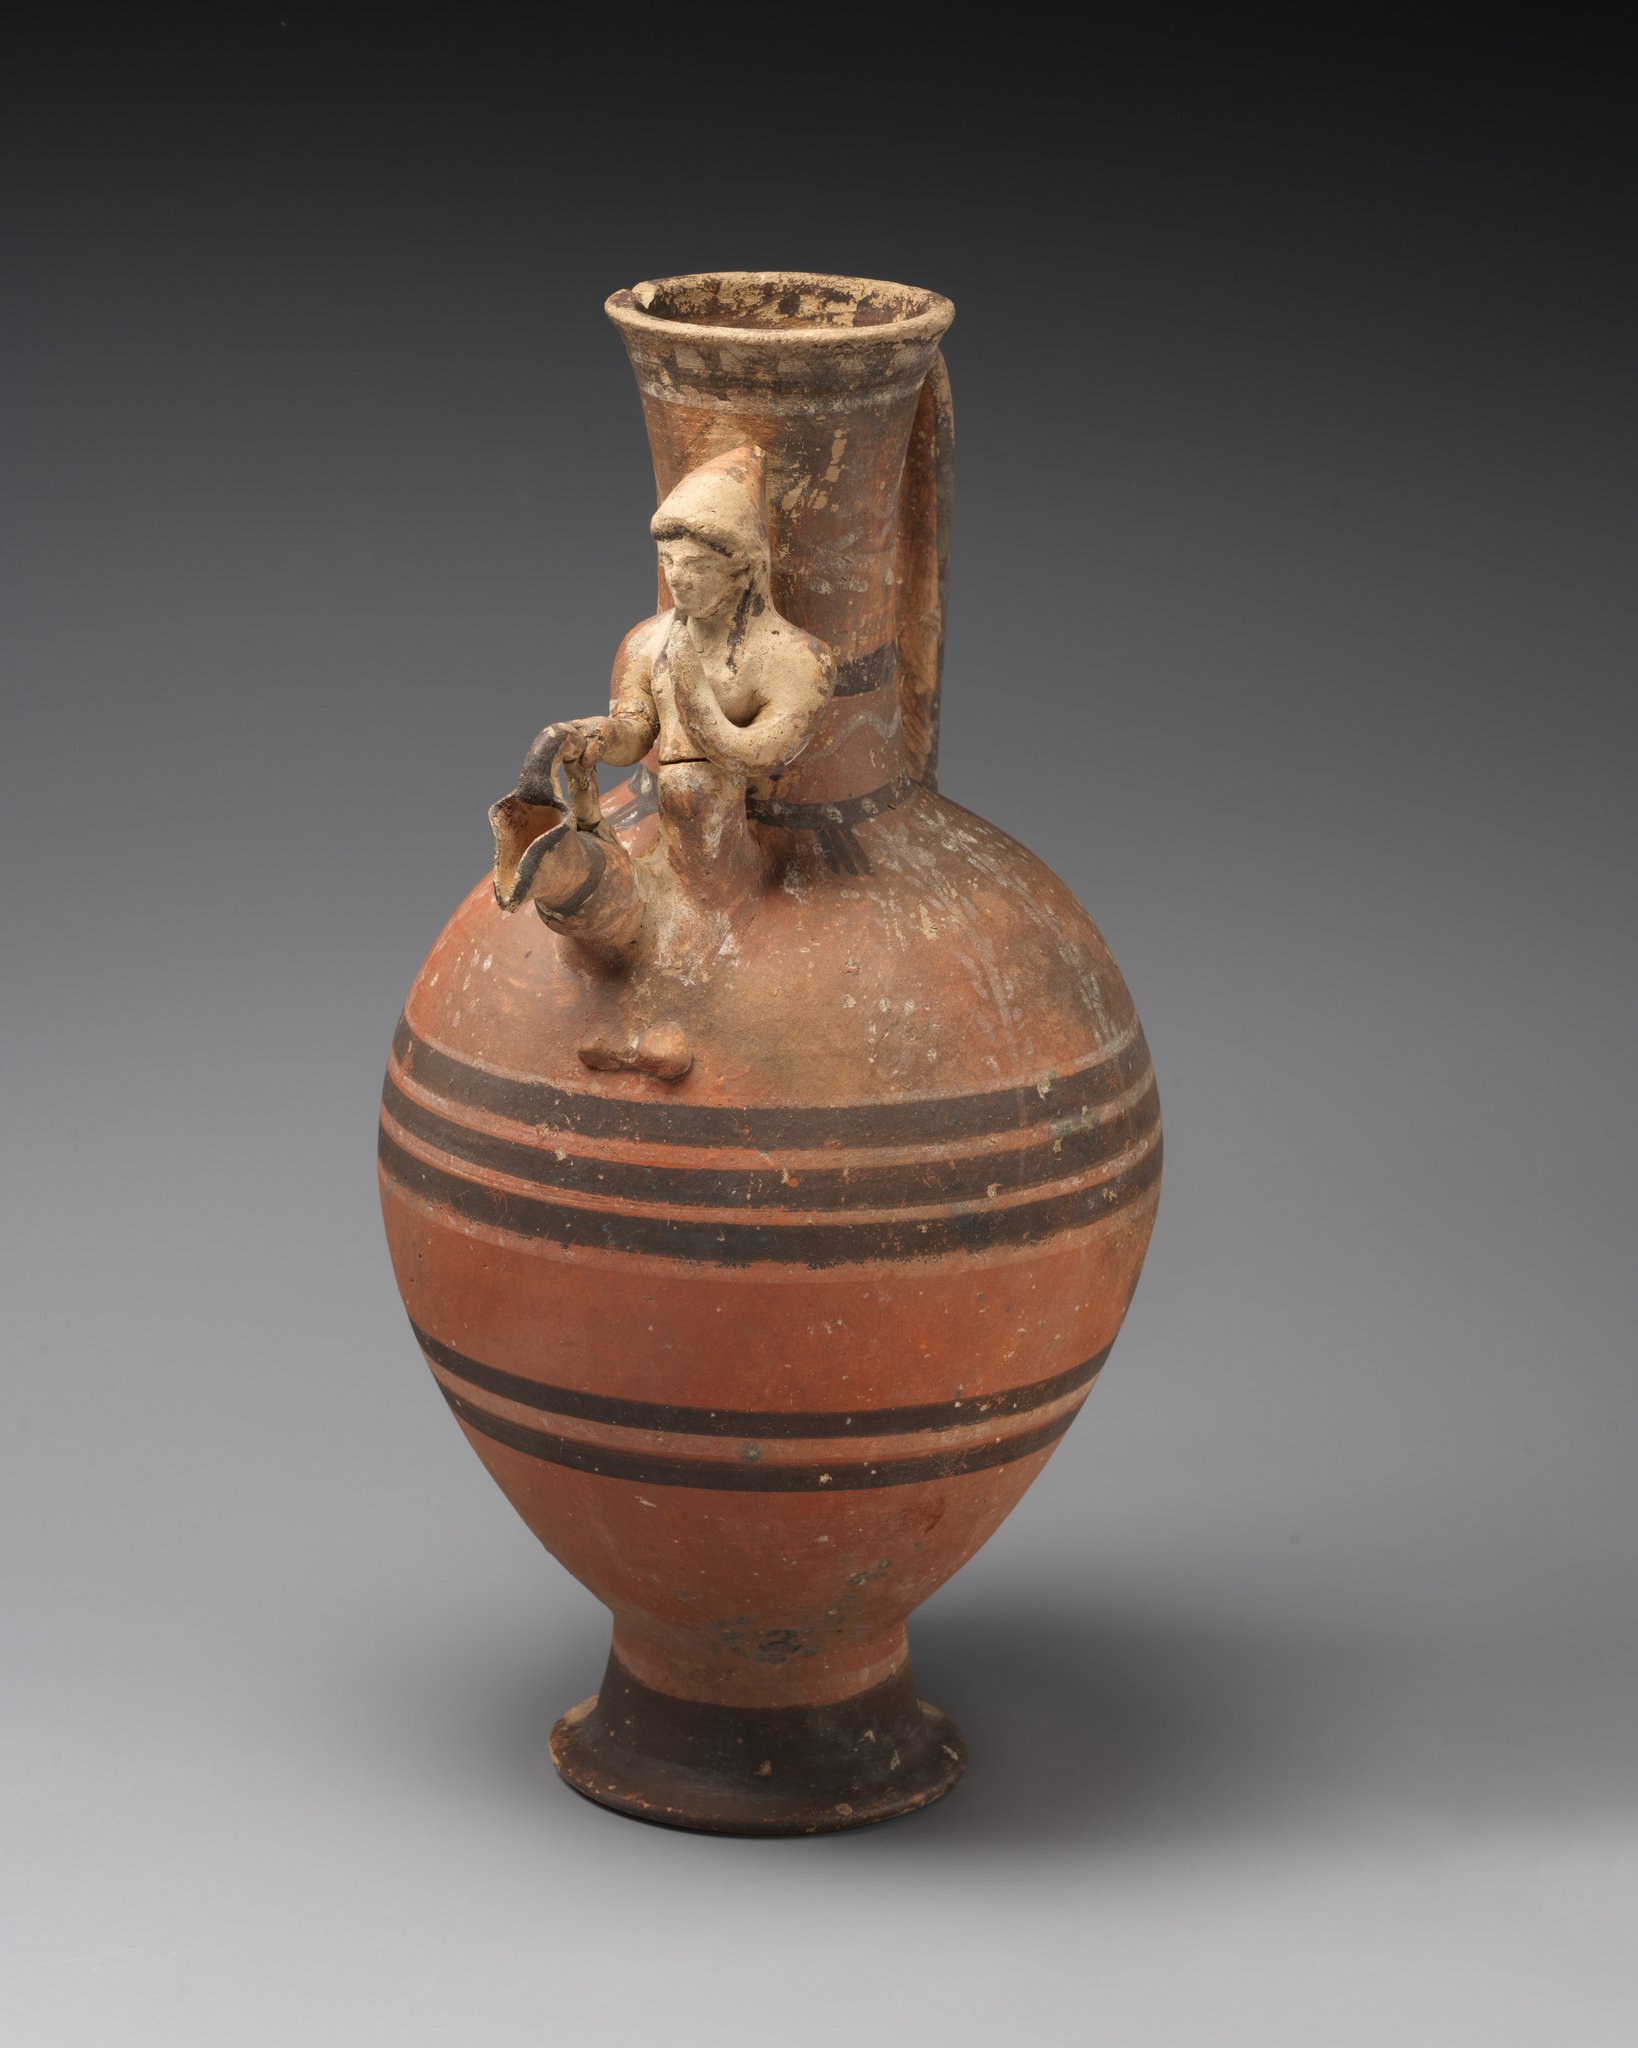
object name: jug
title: Terracotta jug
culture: cypriot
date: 475-400 BCE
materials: terracotta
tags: women